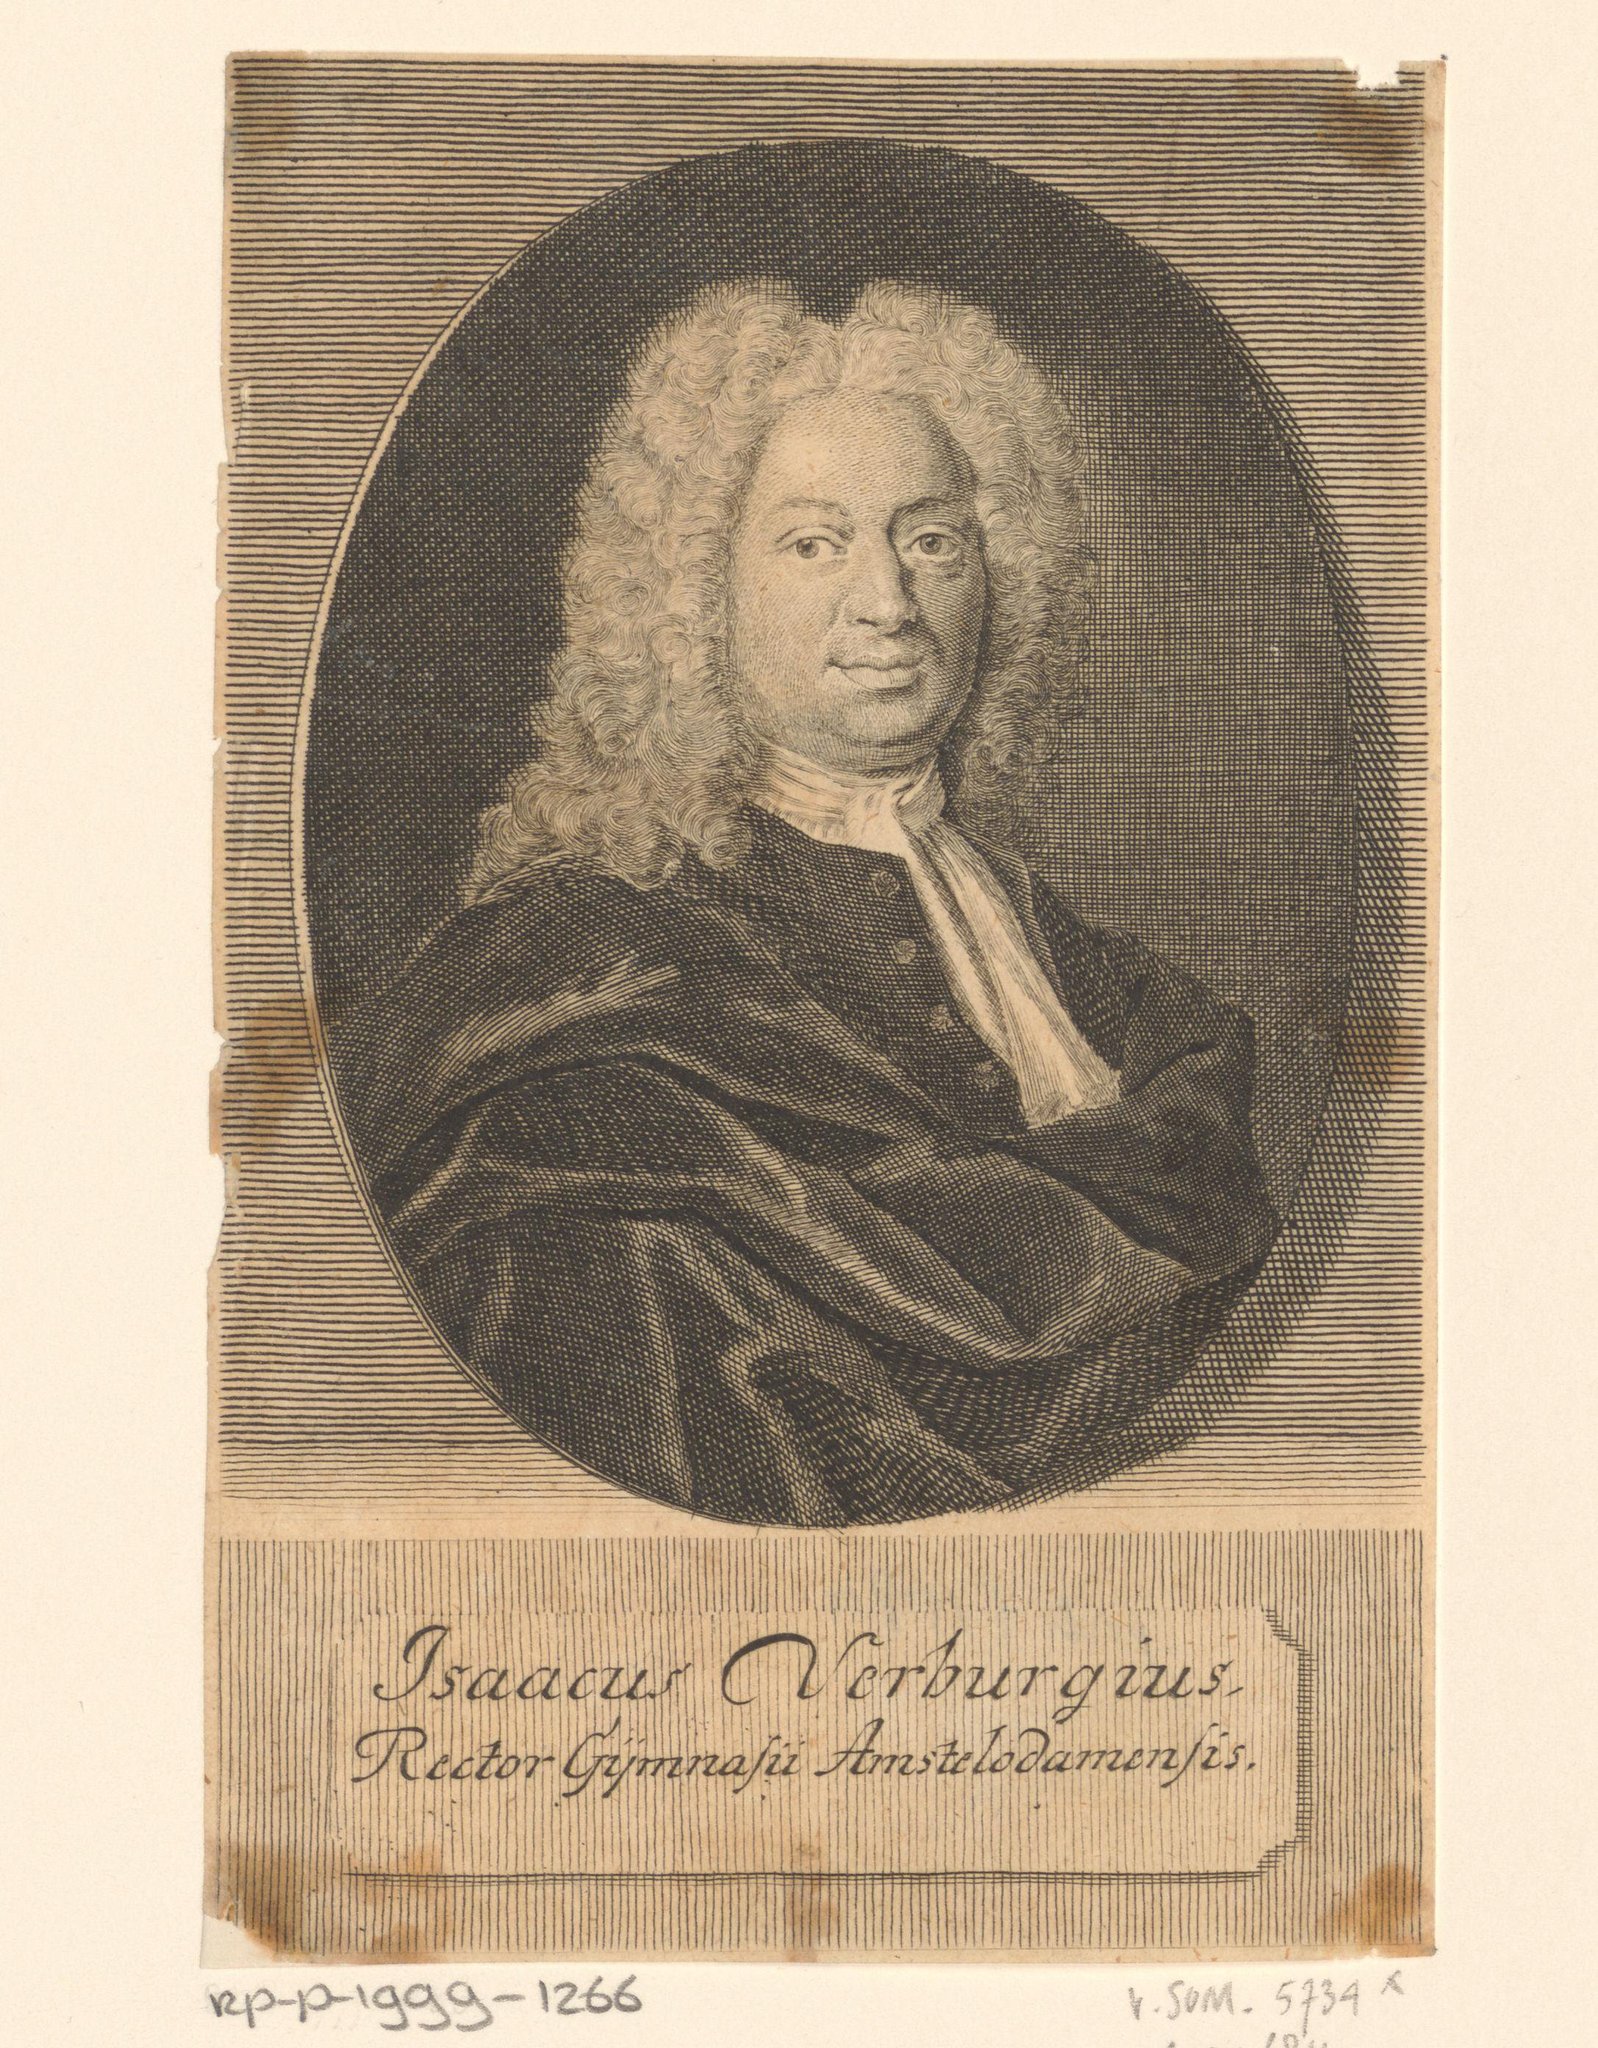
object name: print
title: Portret Isaac Verburg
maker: martin bernigeroth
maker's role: print maker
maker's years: 1670-1733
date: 1727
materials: paper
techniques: engraving, etching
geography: leipzig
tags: amsterdam, isaac verburg, scholar, philosopher, historical persons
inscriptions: collector's mark: Lugt 2760, collector's mark: Lugt 2228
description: Prent waarschijnlijk uit: Deutsche Acta Eruditorum (...). dl. 129. Leipzig: Johann Gottlieb Gleditsch, 1727.